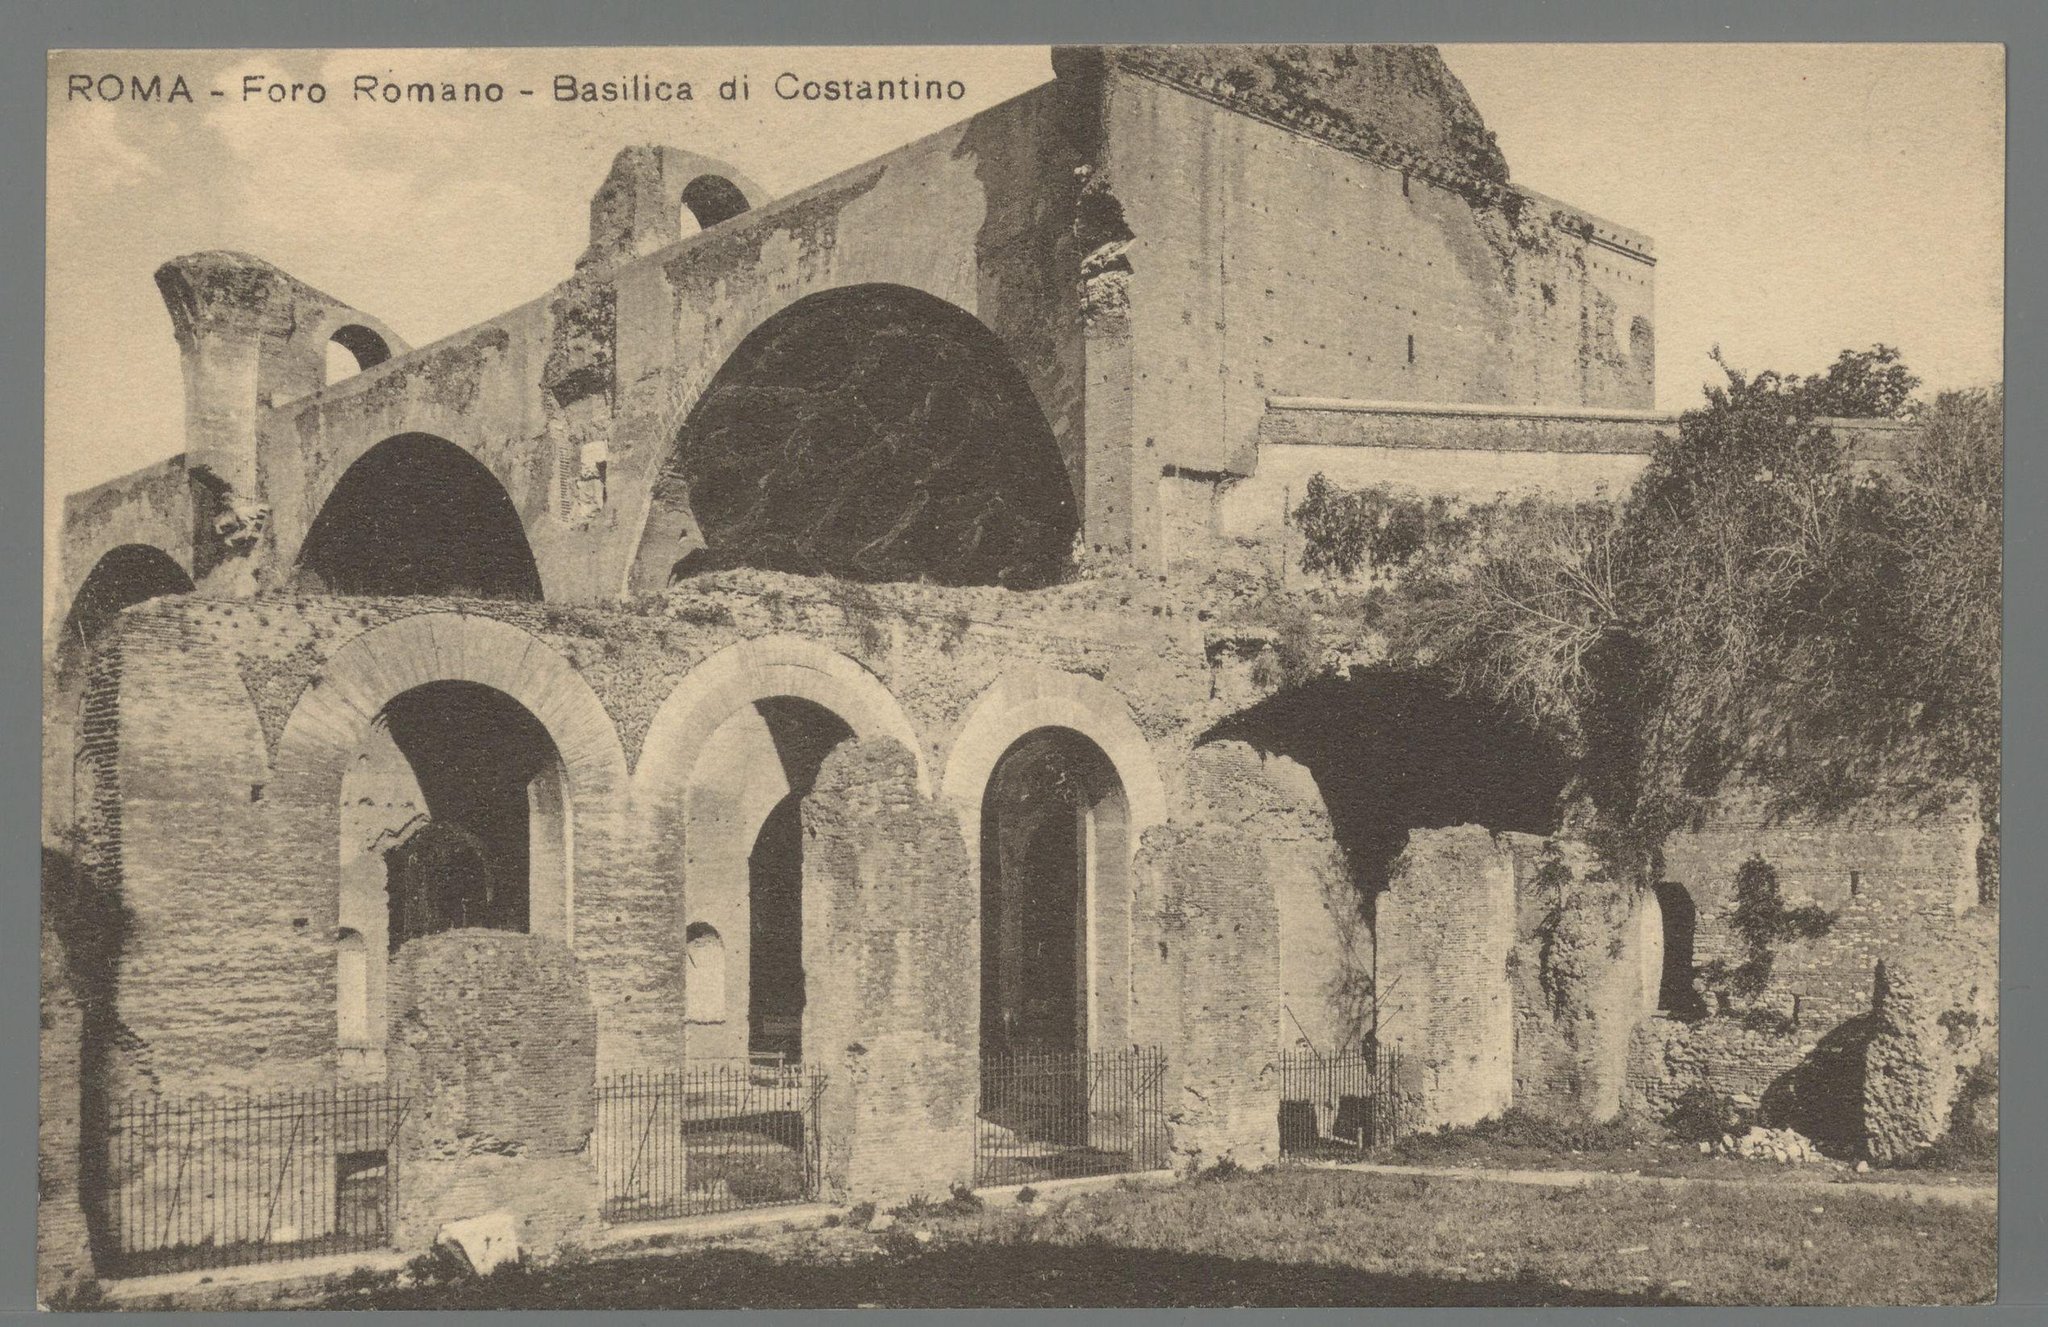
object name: ansichtkaart, prentbriefkaart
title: Roma. Foro Romano. Basilica di Costantino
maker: Anonymous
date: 1906-1920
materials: cardboard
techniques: photograph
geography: rome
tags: ruin of a building ~ architecture, church (exterior)